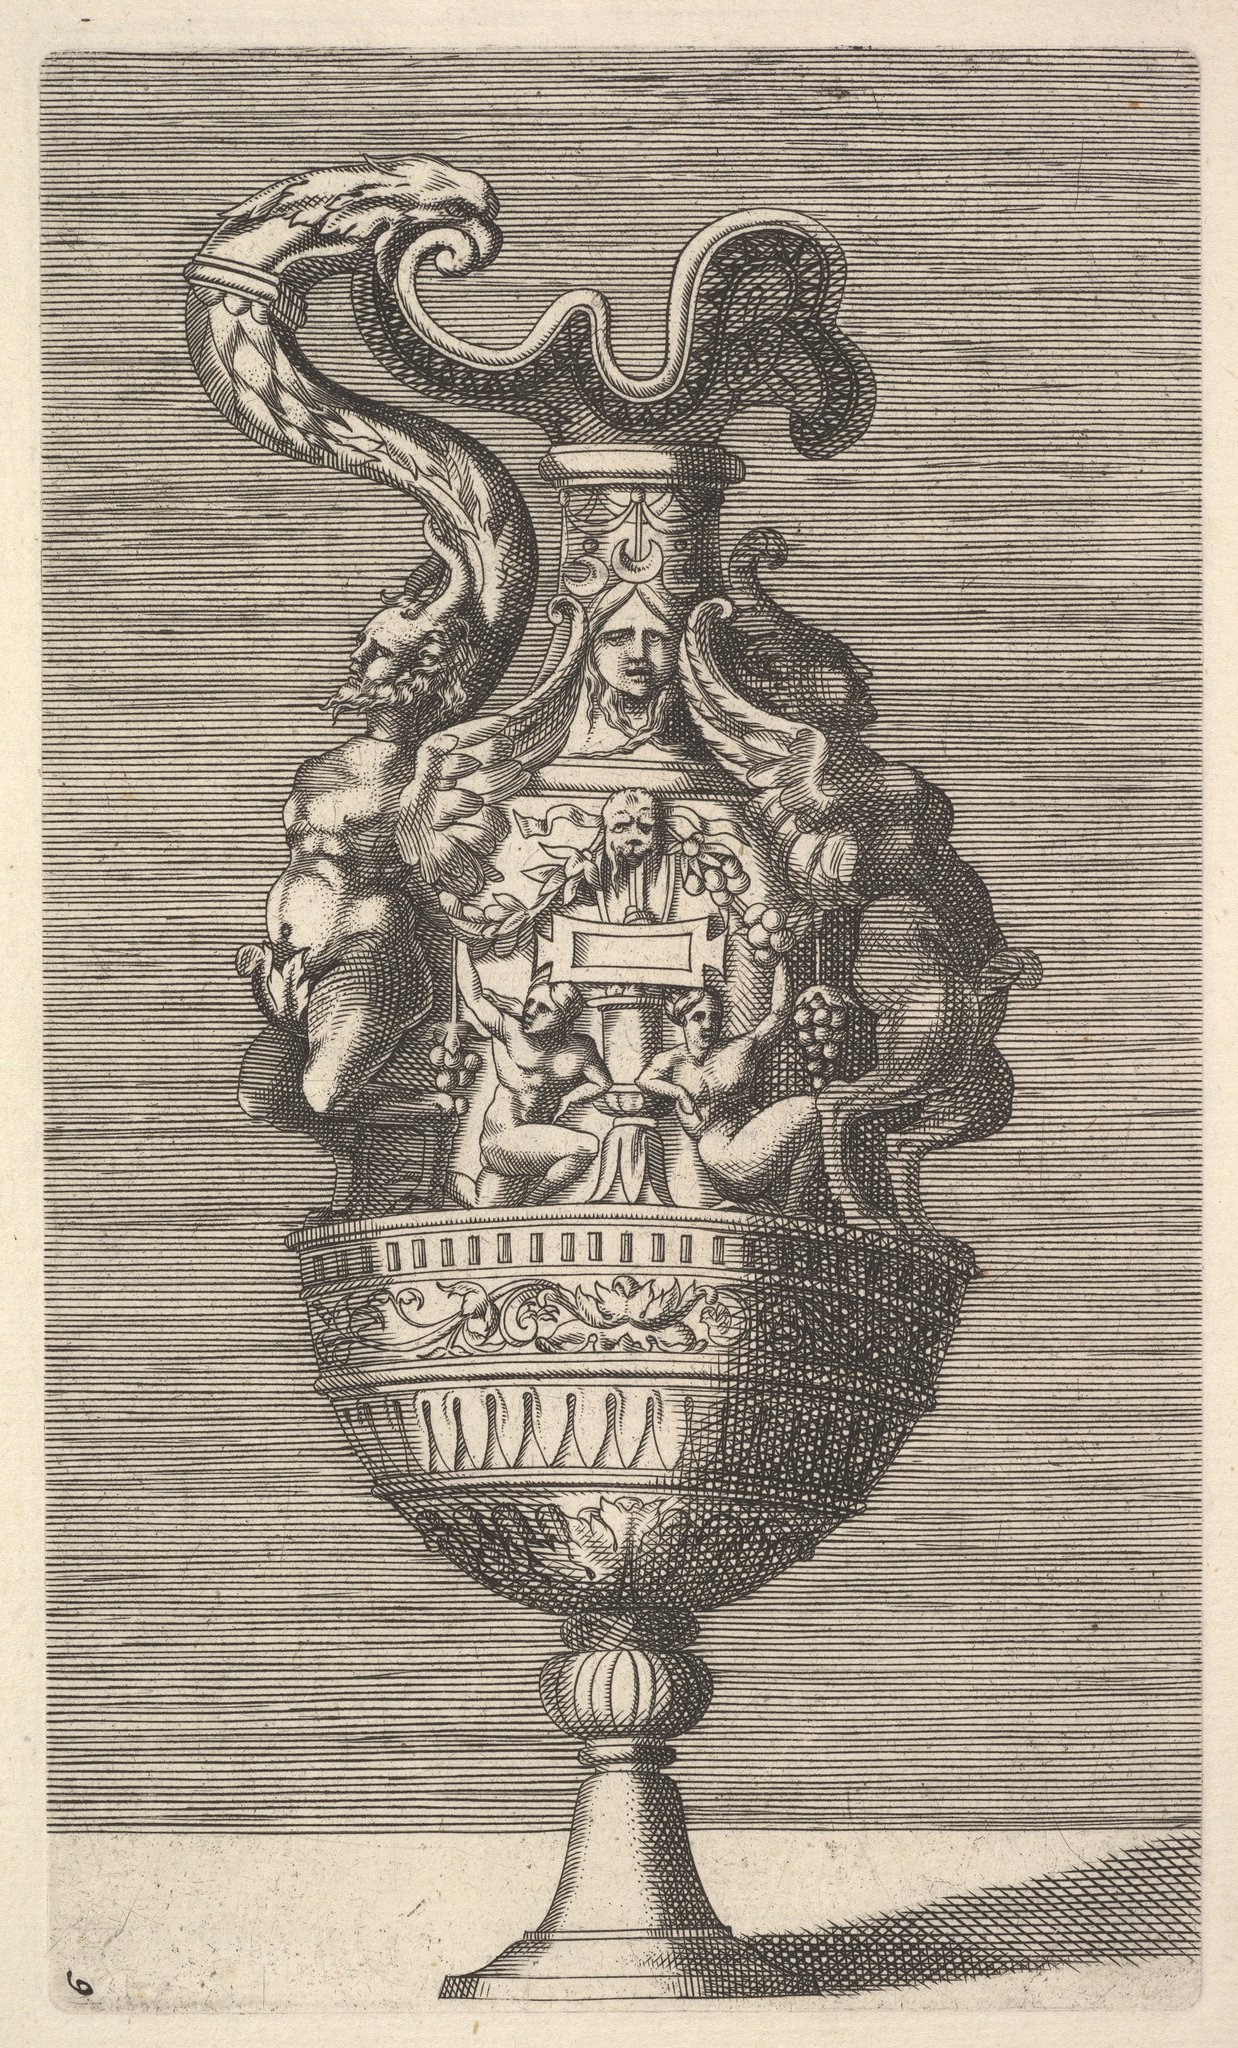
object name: print collection ornament architecture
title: Vase with Two Winged Satyrs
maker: rené boyvin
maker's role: artist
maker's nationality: french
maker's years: 1525-1598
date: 1601-1700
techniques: engraving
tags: satyrs,vases